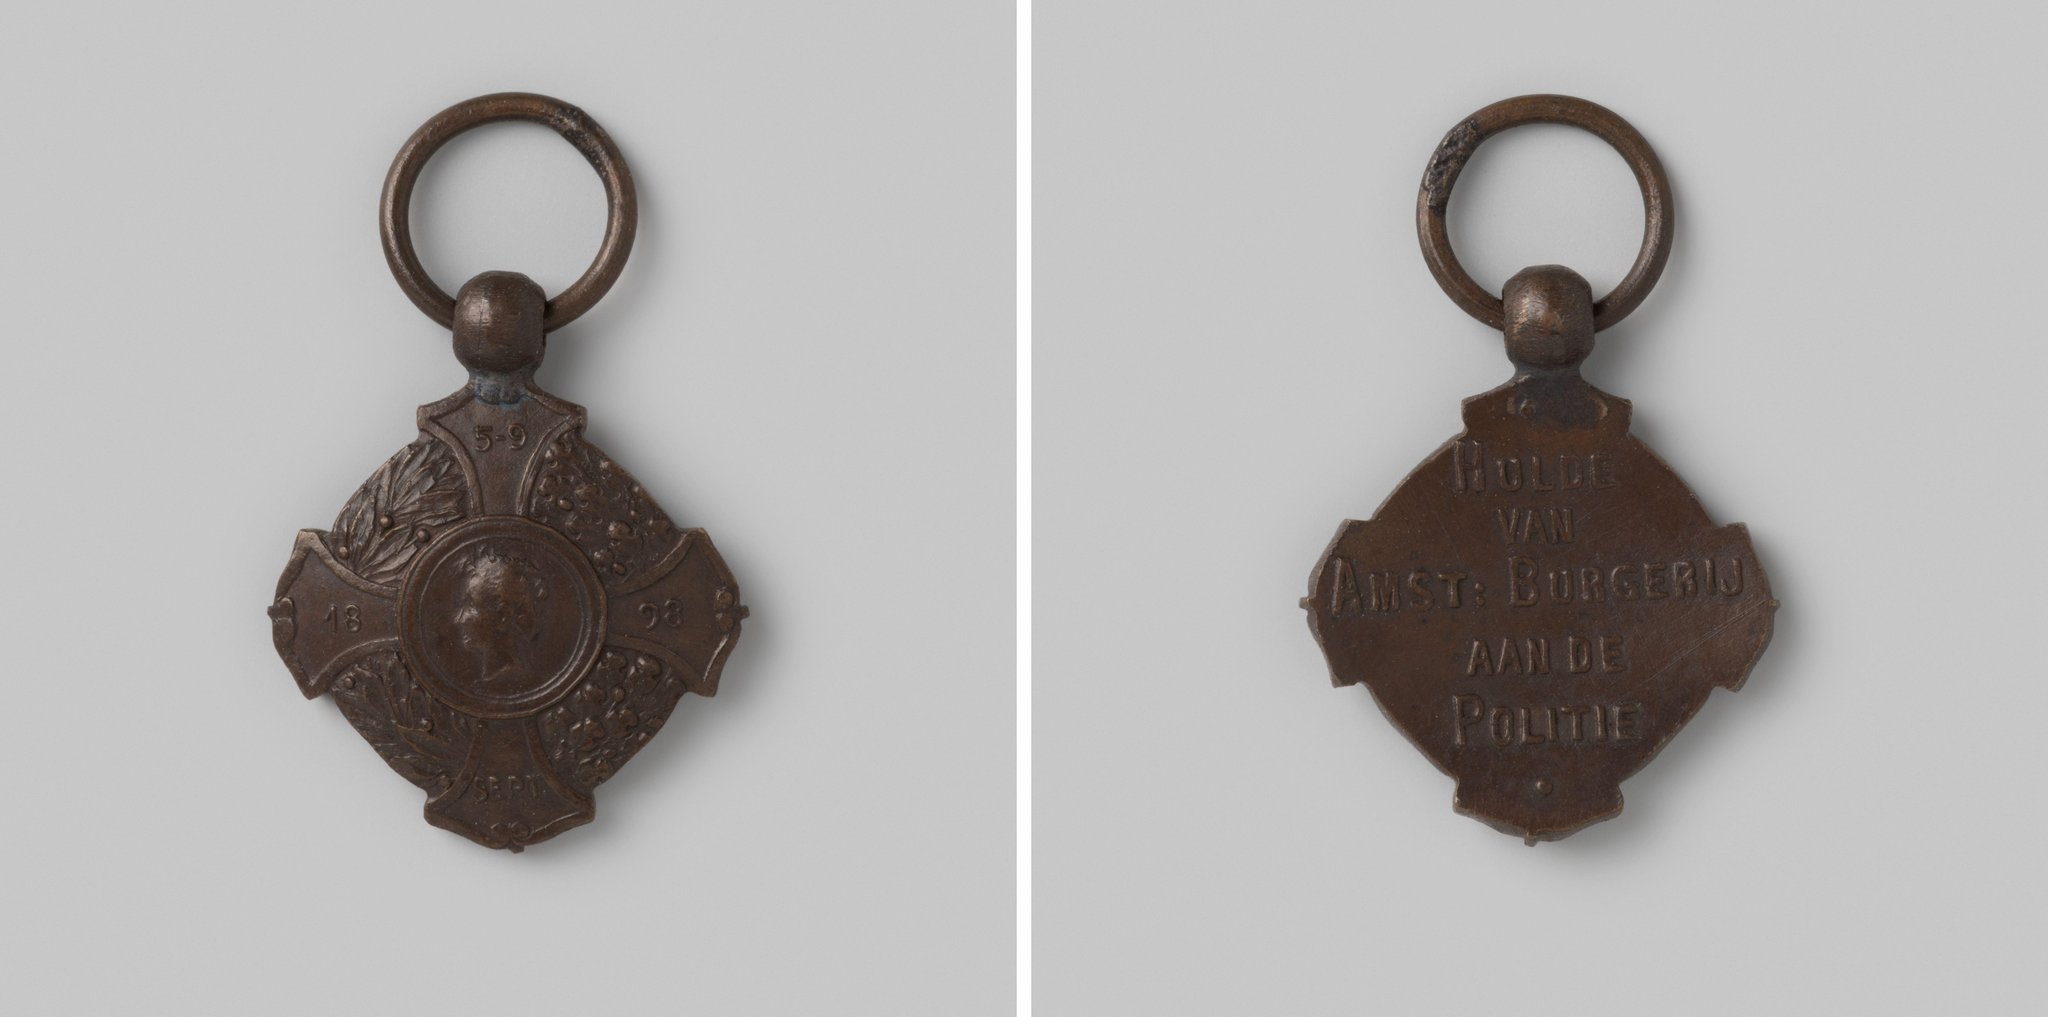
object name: insignia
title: Hulde van de Amsterdamse burgerij aan de politie bij de inhuldiging van Koningin Wilhelmina 1898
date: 1898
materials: bronze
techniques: striking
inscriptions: inscription: ‘5-9 / 18 - 98 / SEPT.’, inscription: ‘HULDE / VAN / AMST BURGERIJ / AAN DE / POLITIE’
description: Klein bronzen draagteken met bal en draagoog, op de voorzijde een kruis met in het midden het portret van Wilhelmina en tussen de benen eiken- en lauwertakken, op de keerzijde vijf regels tekst.